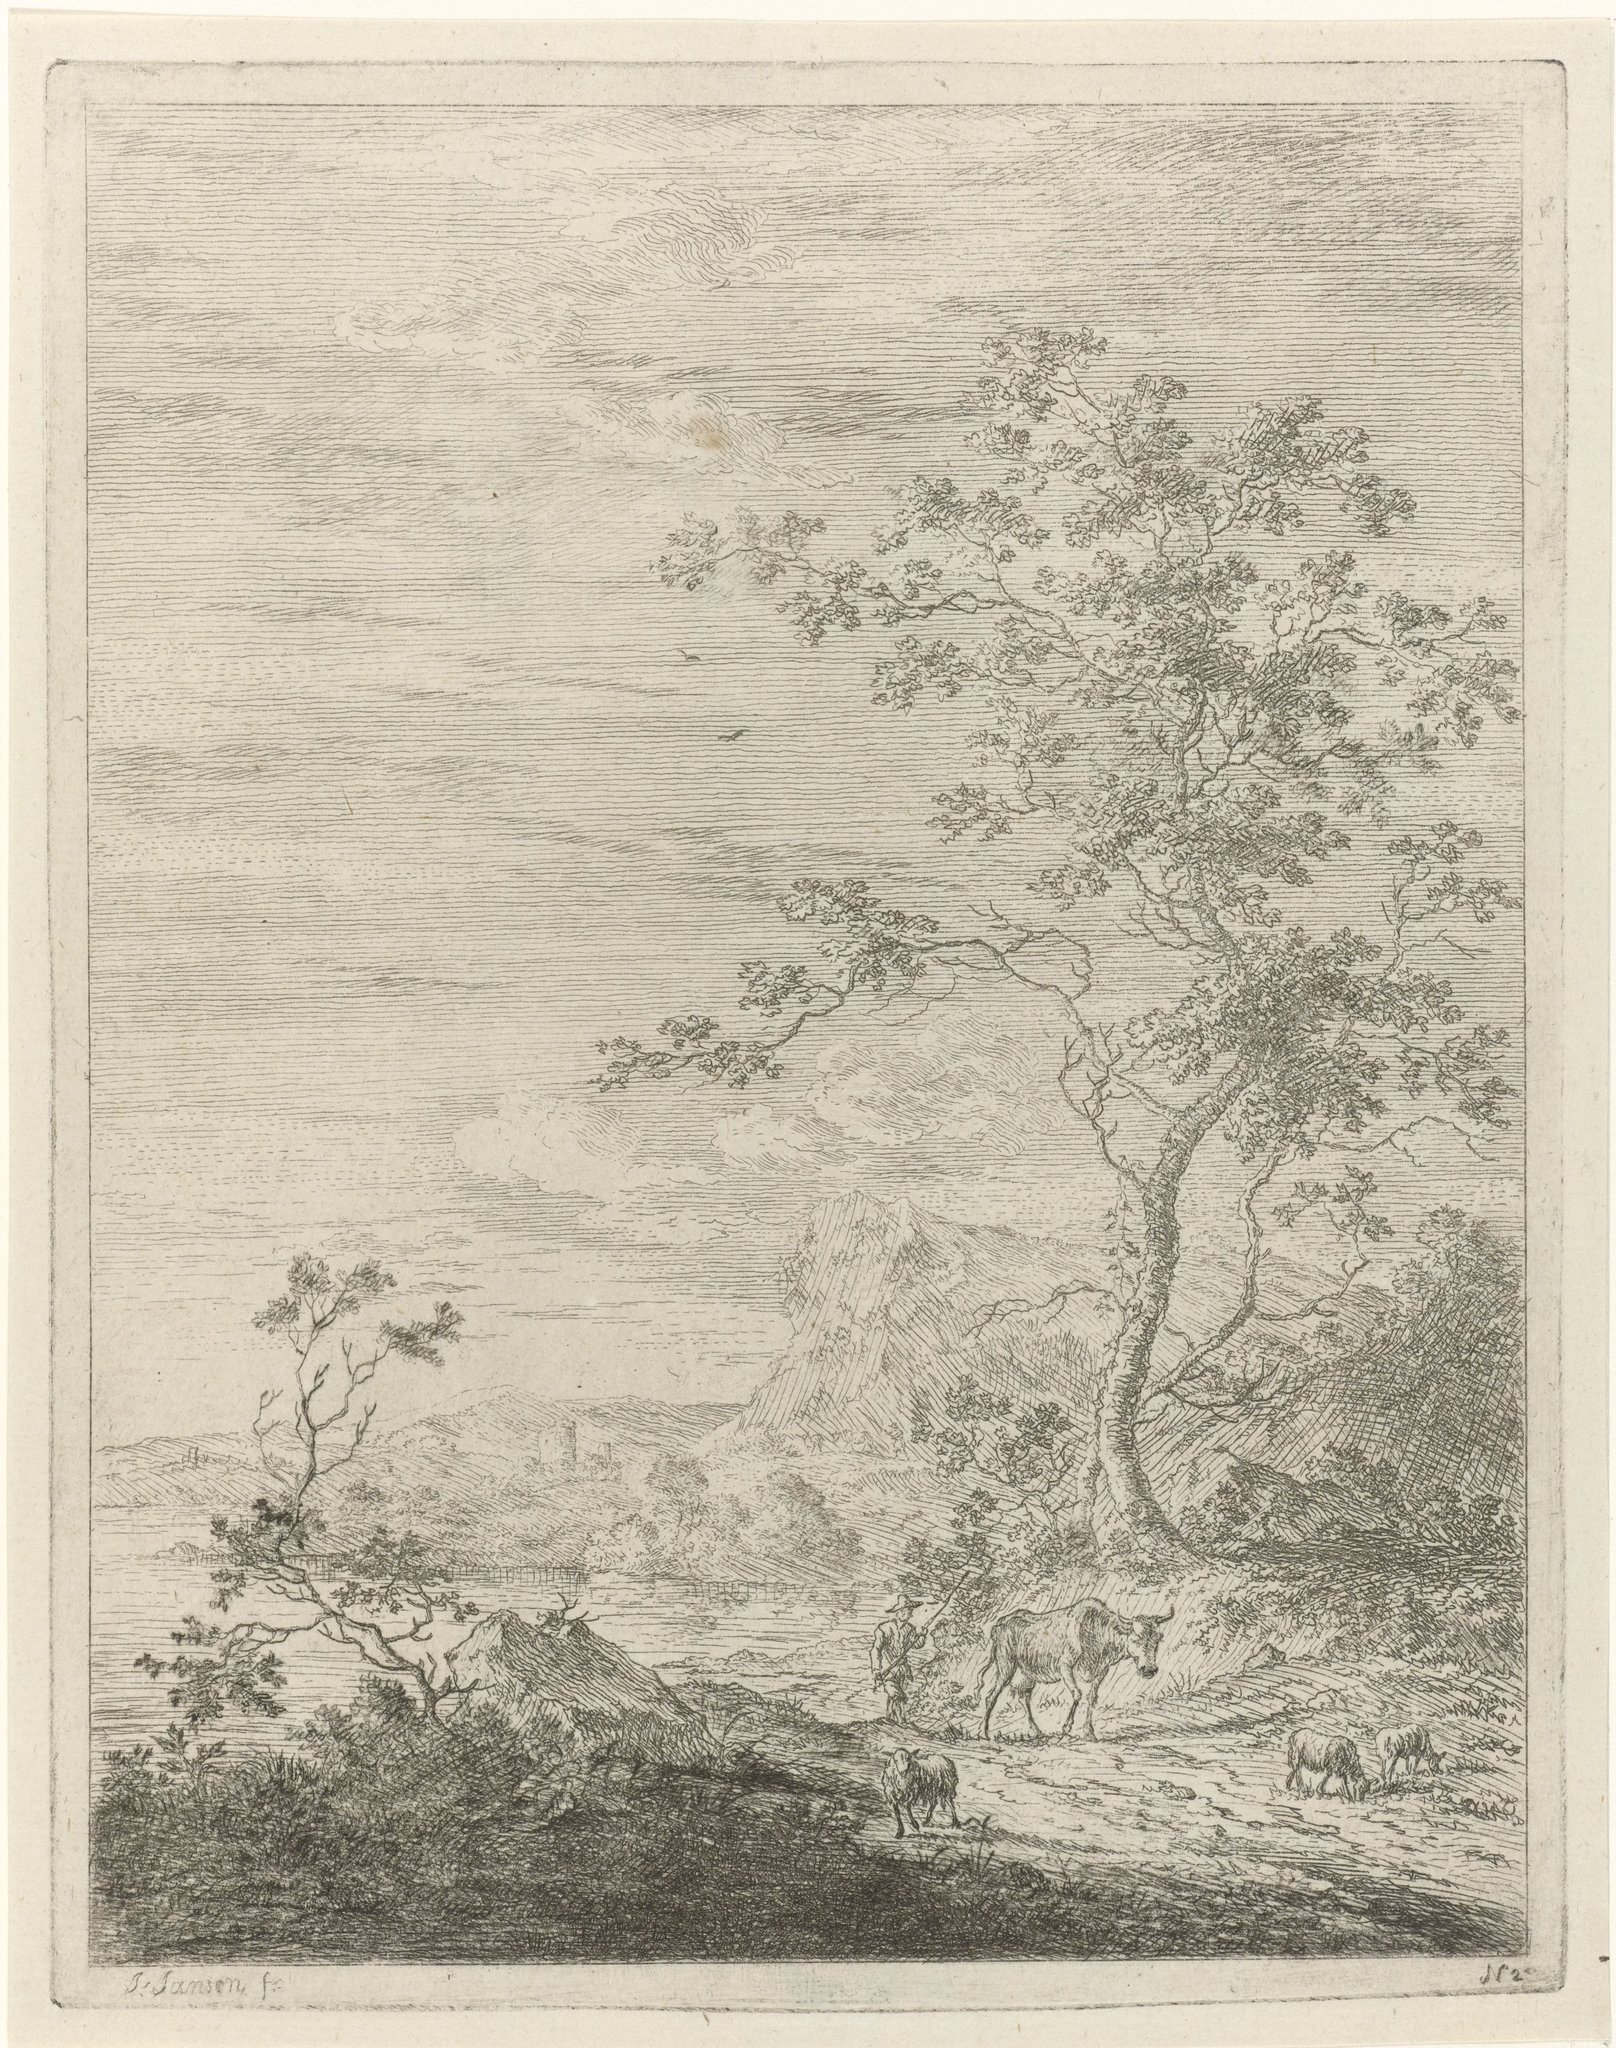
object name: print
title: Bergachtig landschap met herder en vee op pad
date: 1761-1834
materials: paper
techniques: etching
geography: leiden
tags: cow, sheep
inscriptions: collector's mark: Lugt 240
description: Bergachtig landschap met herder, koe en schapen op een pad. Links op de achtergrond een meer. Rechtsonder: N.2. Kopie in spiegelbeeld naar gelijknamige prent van Johannes Janson.